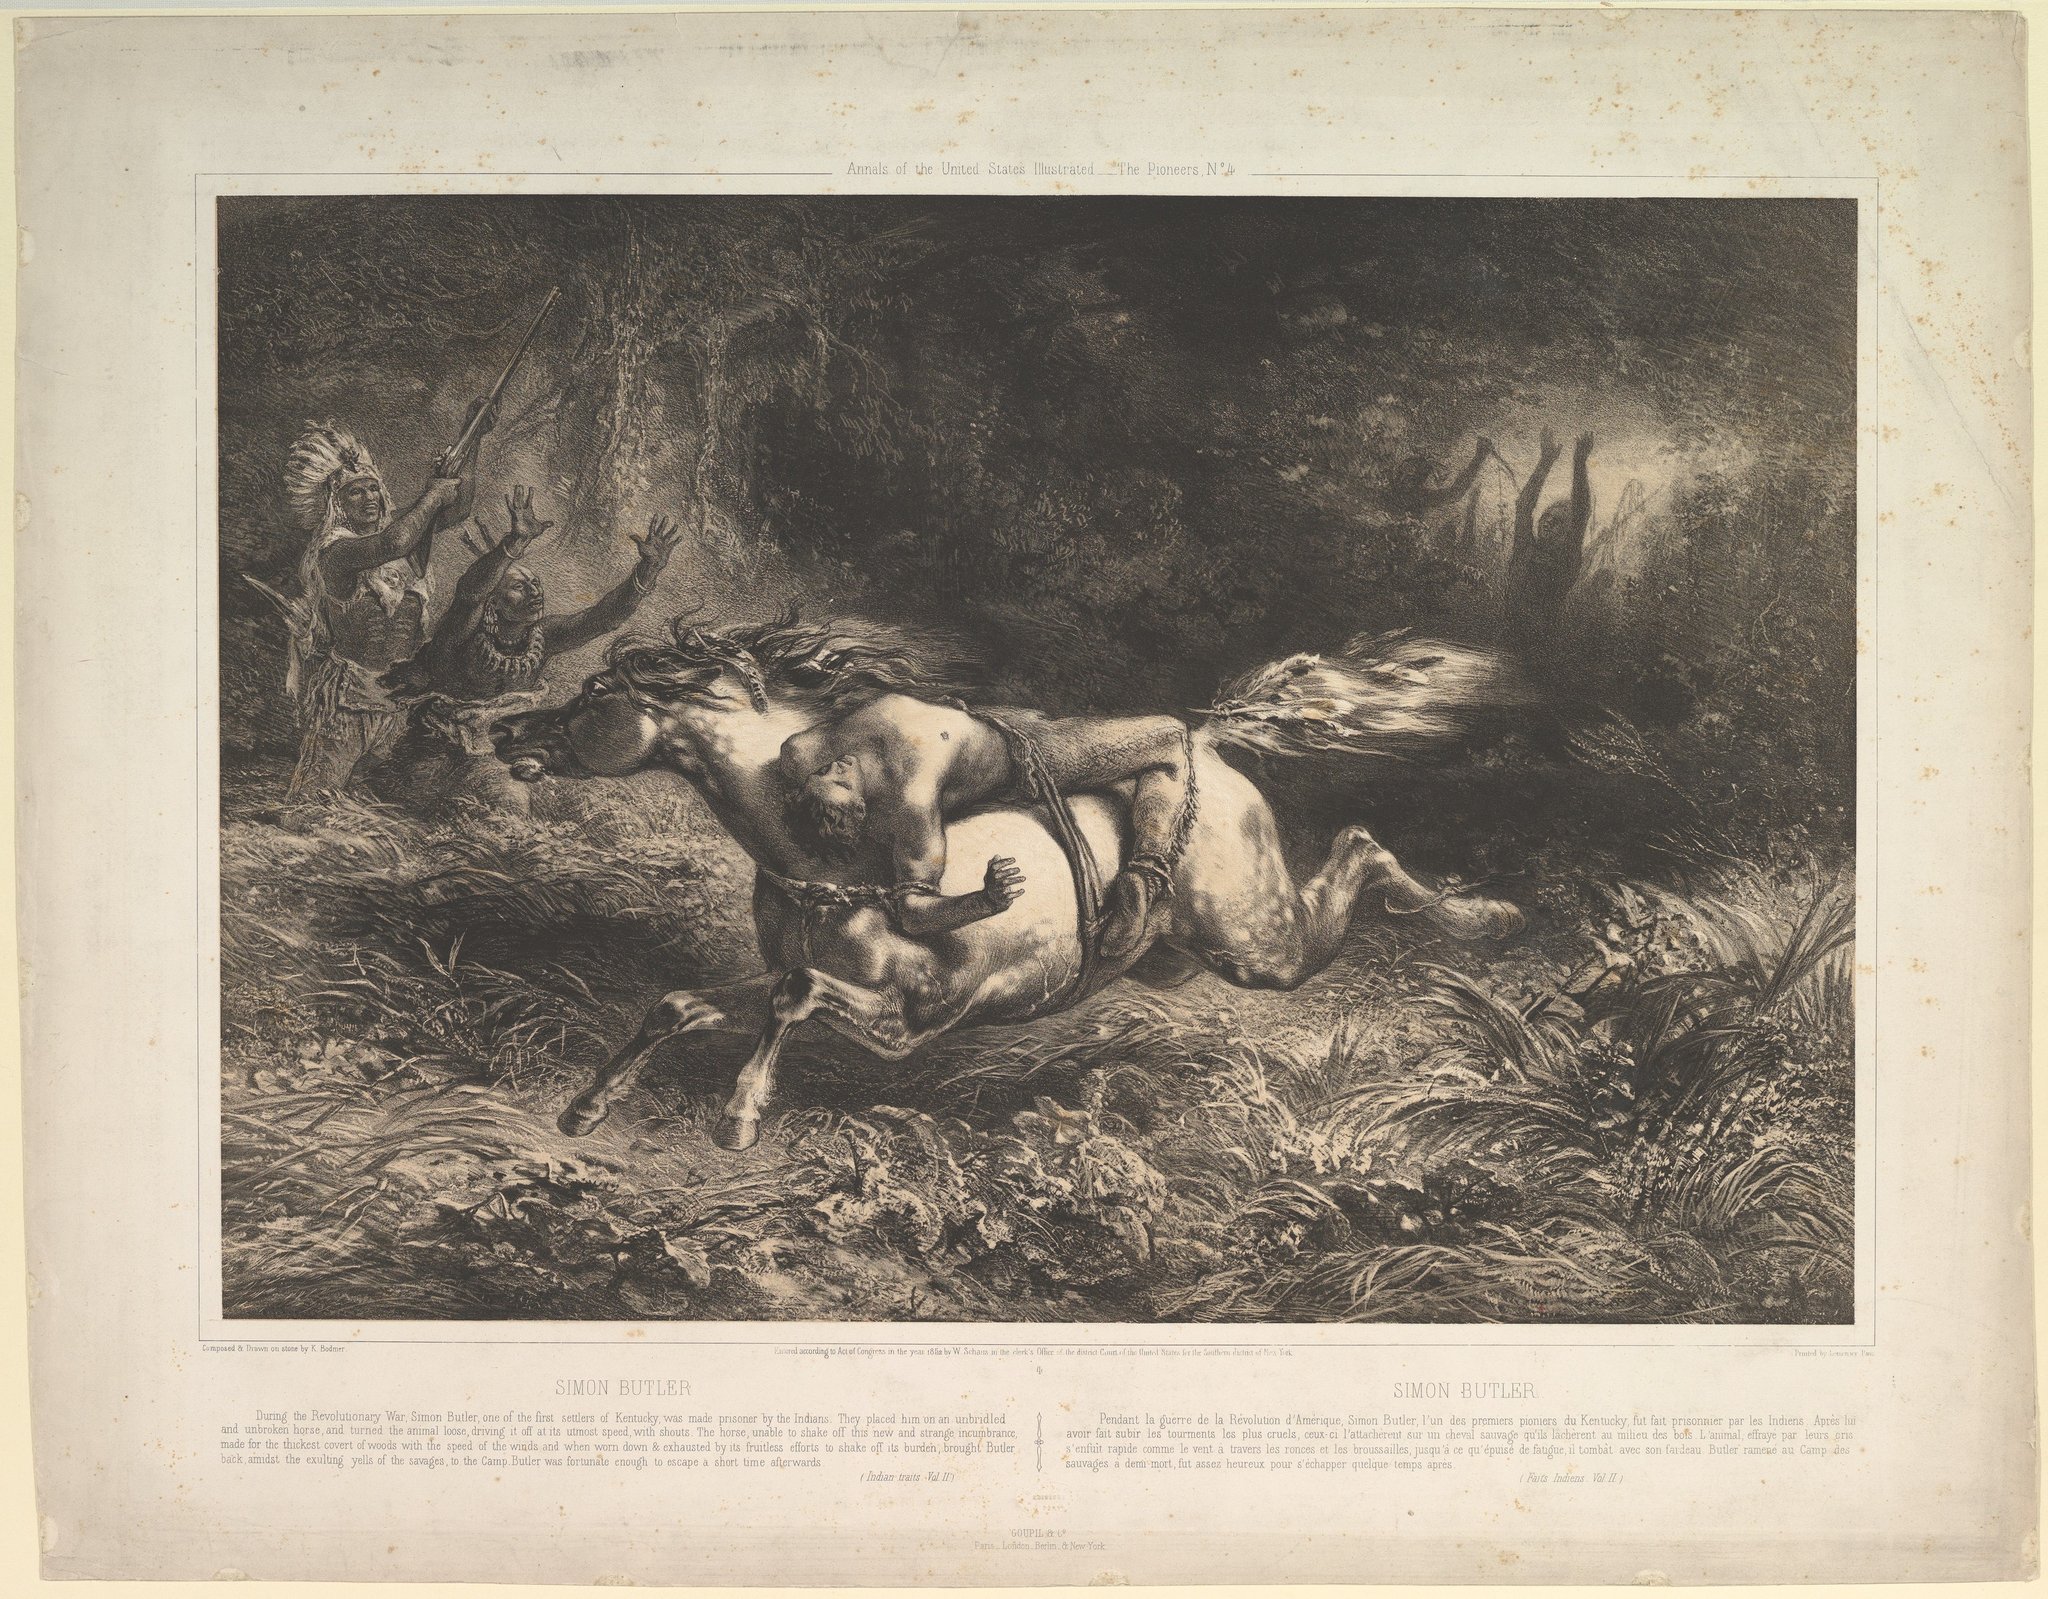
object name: print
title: Simon Butler (Indian Trails, vol. II)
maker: jean-françois millet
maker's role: artist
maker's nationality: french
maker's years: 1814-1875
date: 1852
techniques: printmaking, lithograph, printing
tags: men,horses